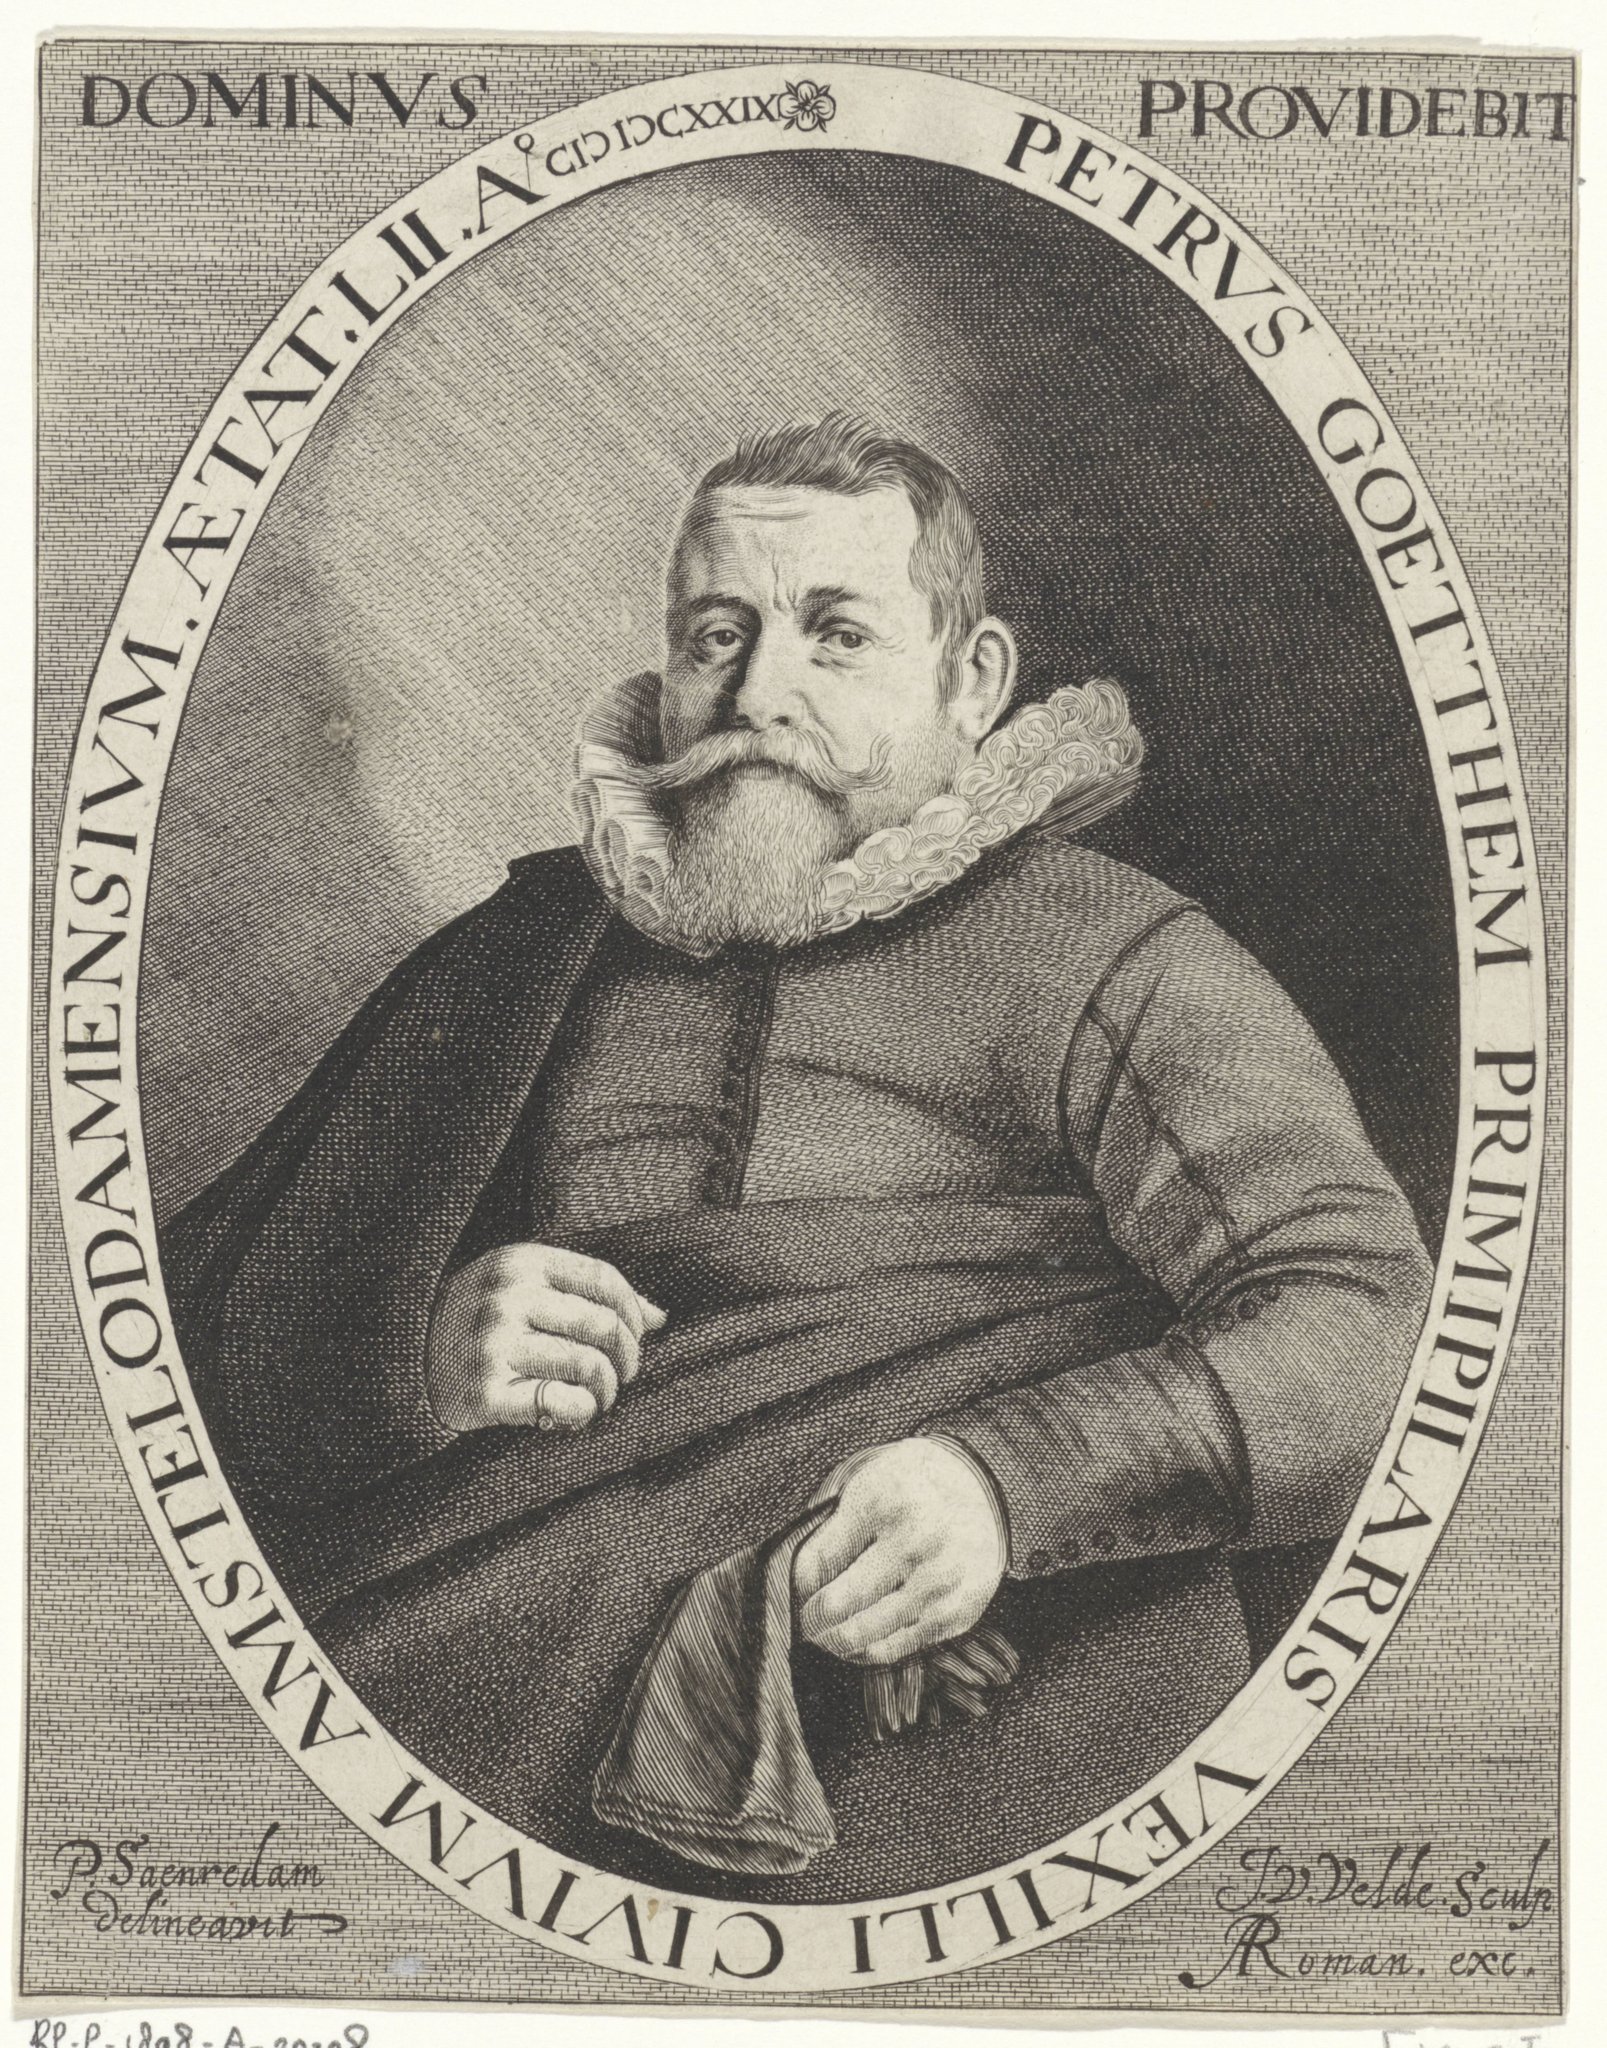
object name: print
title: Portret van Petrus Goetthem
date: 1629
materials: paper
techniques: engraving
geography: northern netherlands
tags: petrus goetthem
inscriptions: collector's mark: Lugt 964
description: Portret van Petrus Goetthem, kapitein van de schutterij van Amsterdam, op 52-jarige leeftijd.